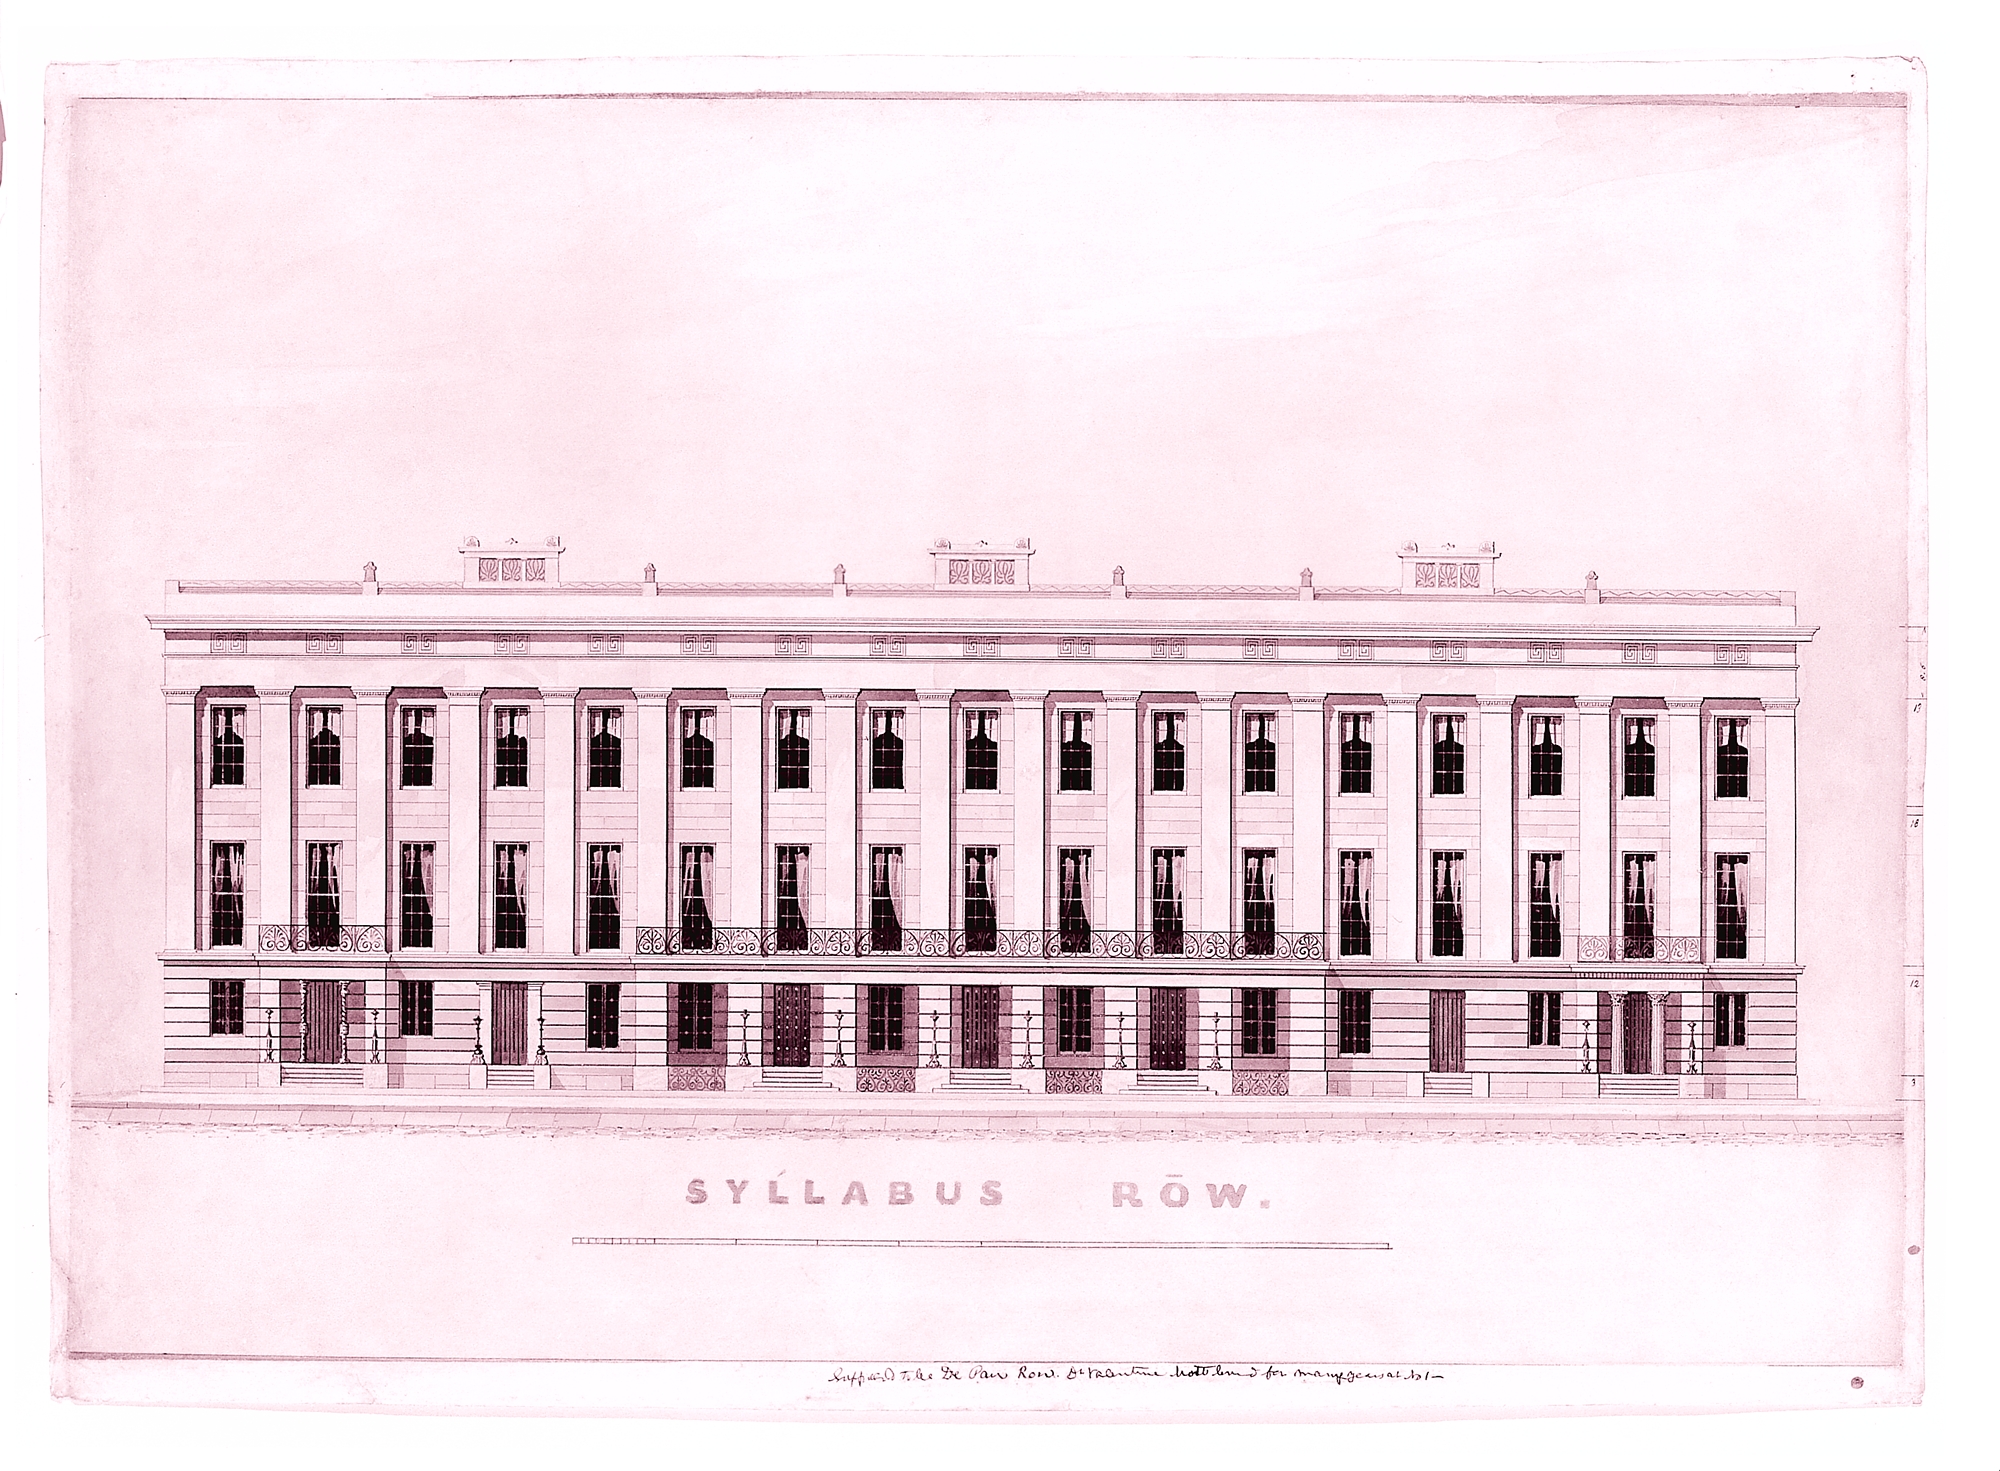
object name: drawing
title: Syllabus Row, New York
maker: alexander jackson davis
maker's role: artist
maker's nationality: american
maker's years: 1803-1892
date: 1801-1900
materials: paper, watercolor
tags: architecture,buildings